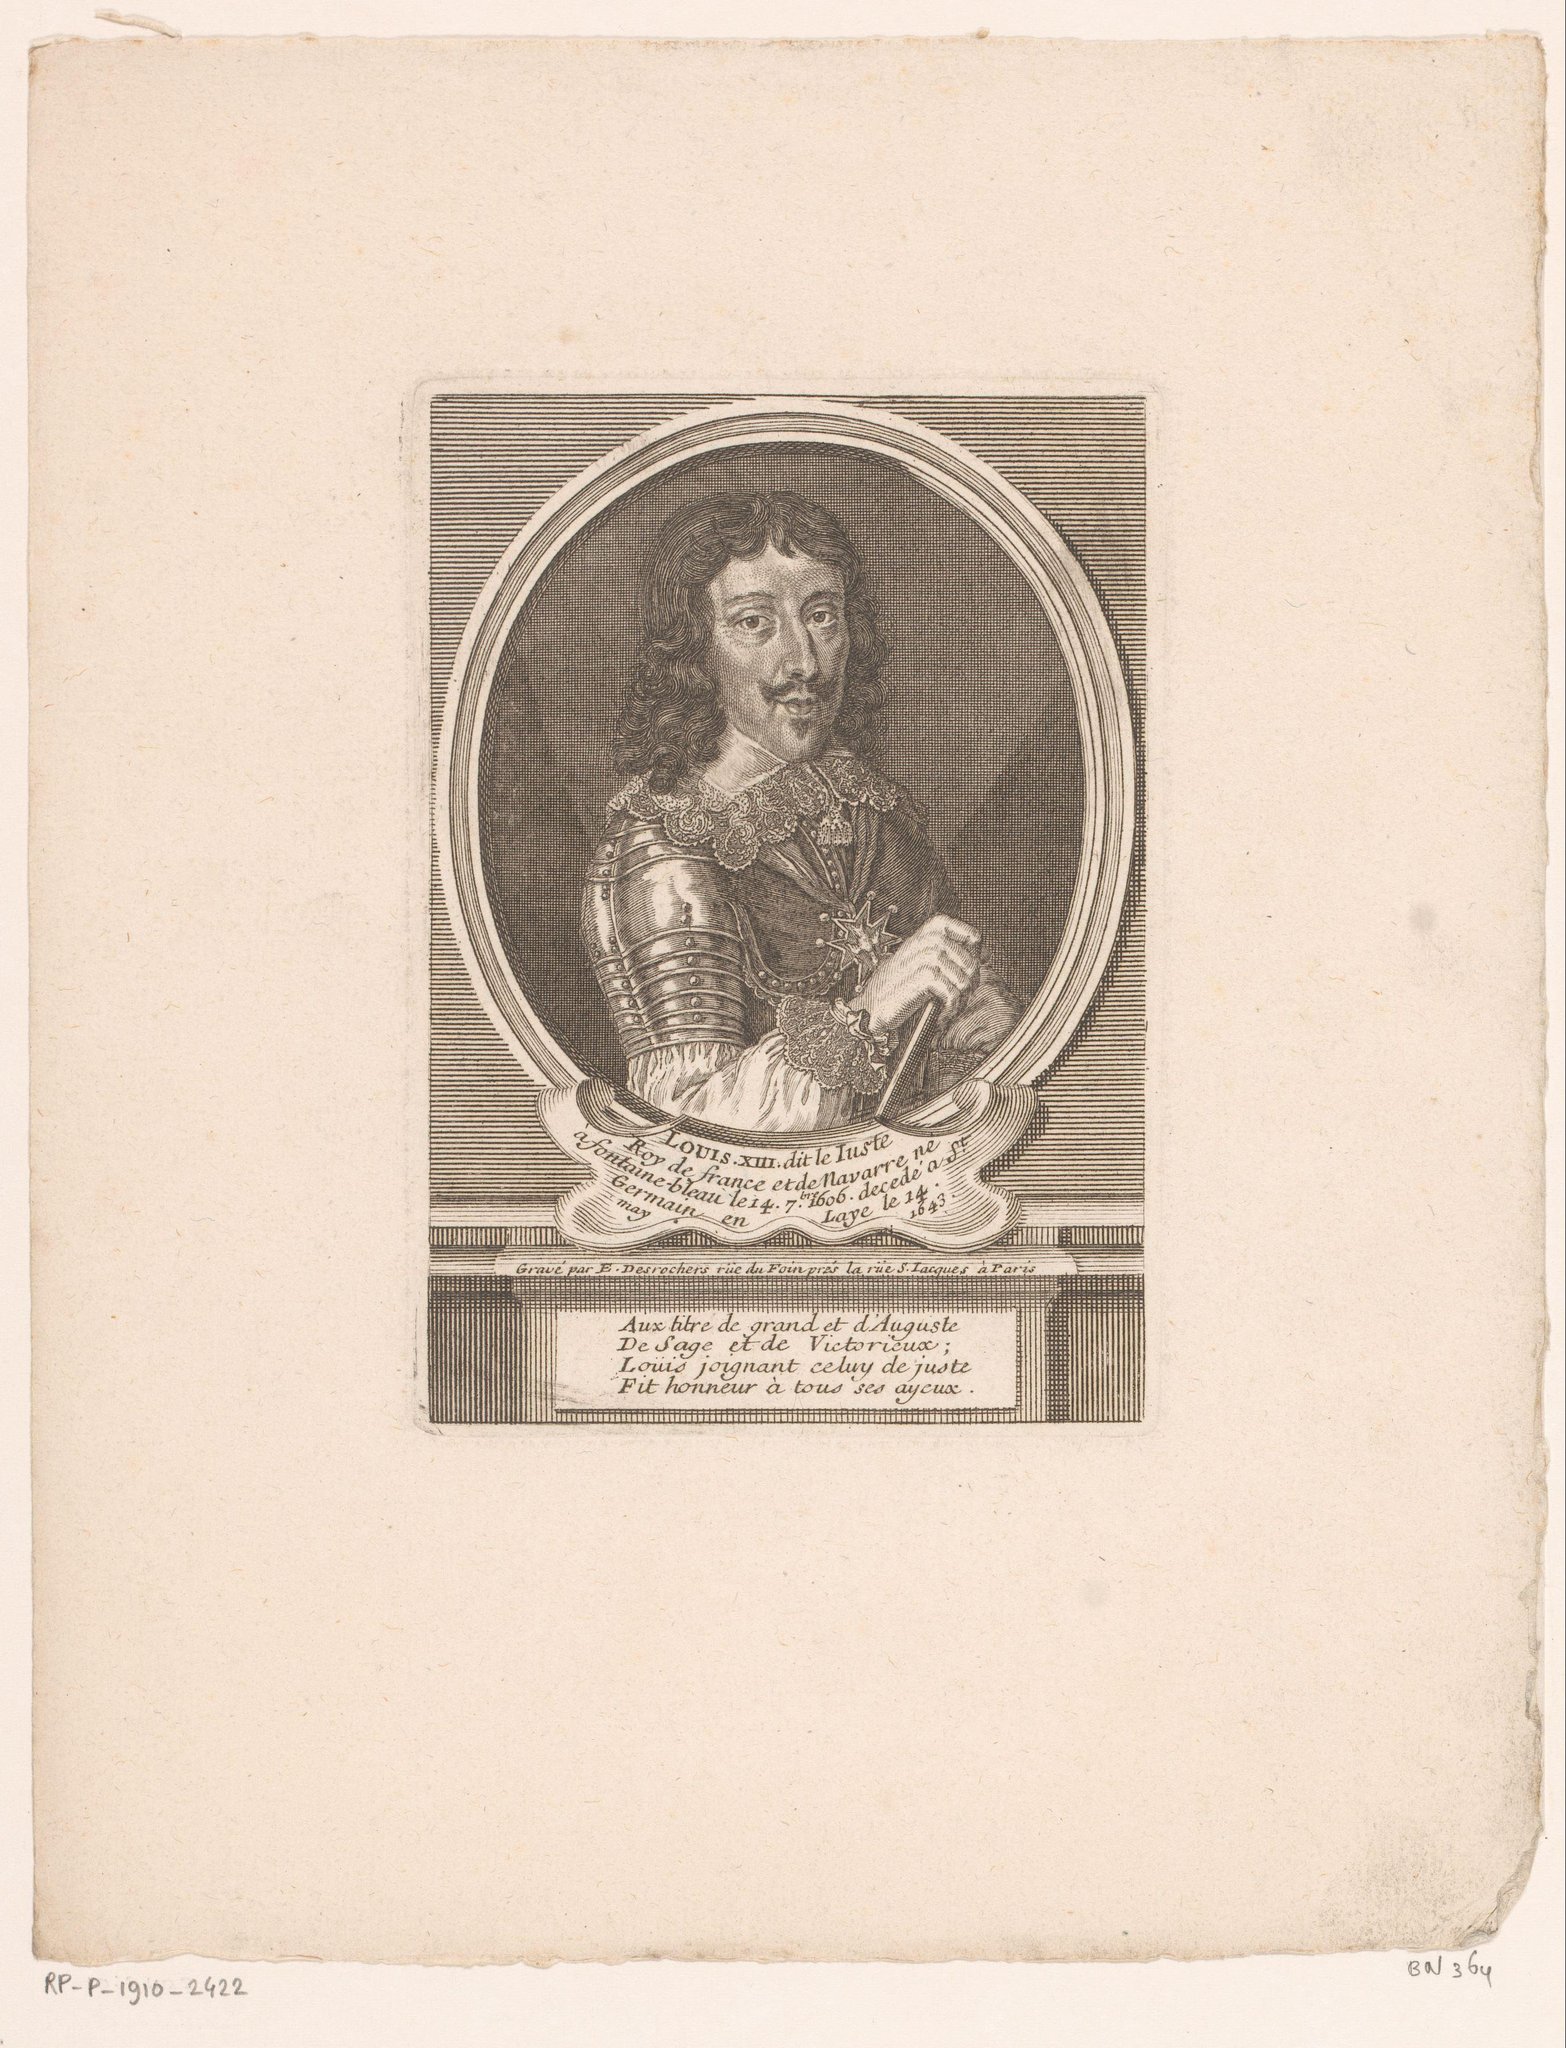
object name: print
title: Portret van koning Lodewijk XIII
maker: étienne desrochers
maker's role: print maker, publisher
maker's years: 1668-1741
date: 1726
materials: paper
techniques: engraving, etching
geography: paris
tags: lodewijk xiii (koning van frankrijk), historical persons, king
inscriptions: collector's mark: Lugt 2228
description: Behoort waarschijnlijk tot een serie portretten, grotendeels door Etienne Desrochers, getiteld: 'Recueil de portraits de personnes qui se sont distinguées tant dans les Armes que dans Belles-Lettres et les Arts, comme aussi la famille royale de France et autres cours étrangères'. De serie werd initieel uitgegeven door Desrochers en aangekondigd in 'Mercure' in mei 1726, p. 985. Echter was Desrochers reeds enkele jaren eerder begonnen met het uitgeven van de serie. Na de dood van Desrochers werd de serie voortgezet door Gilles Edme Petit. Een latere staat werd uitgegeven door Jean François Daumont in Parijs.